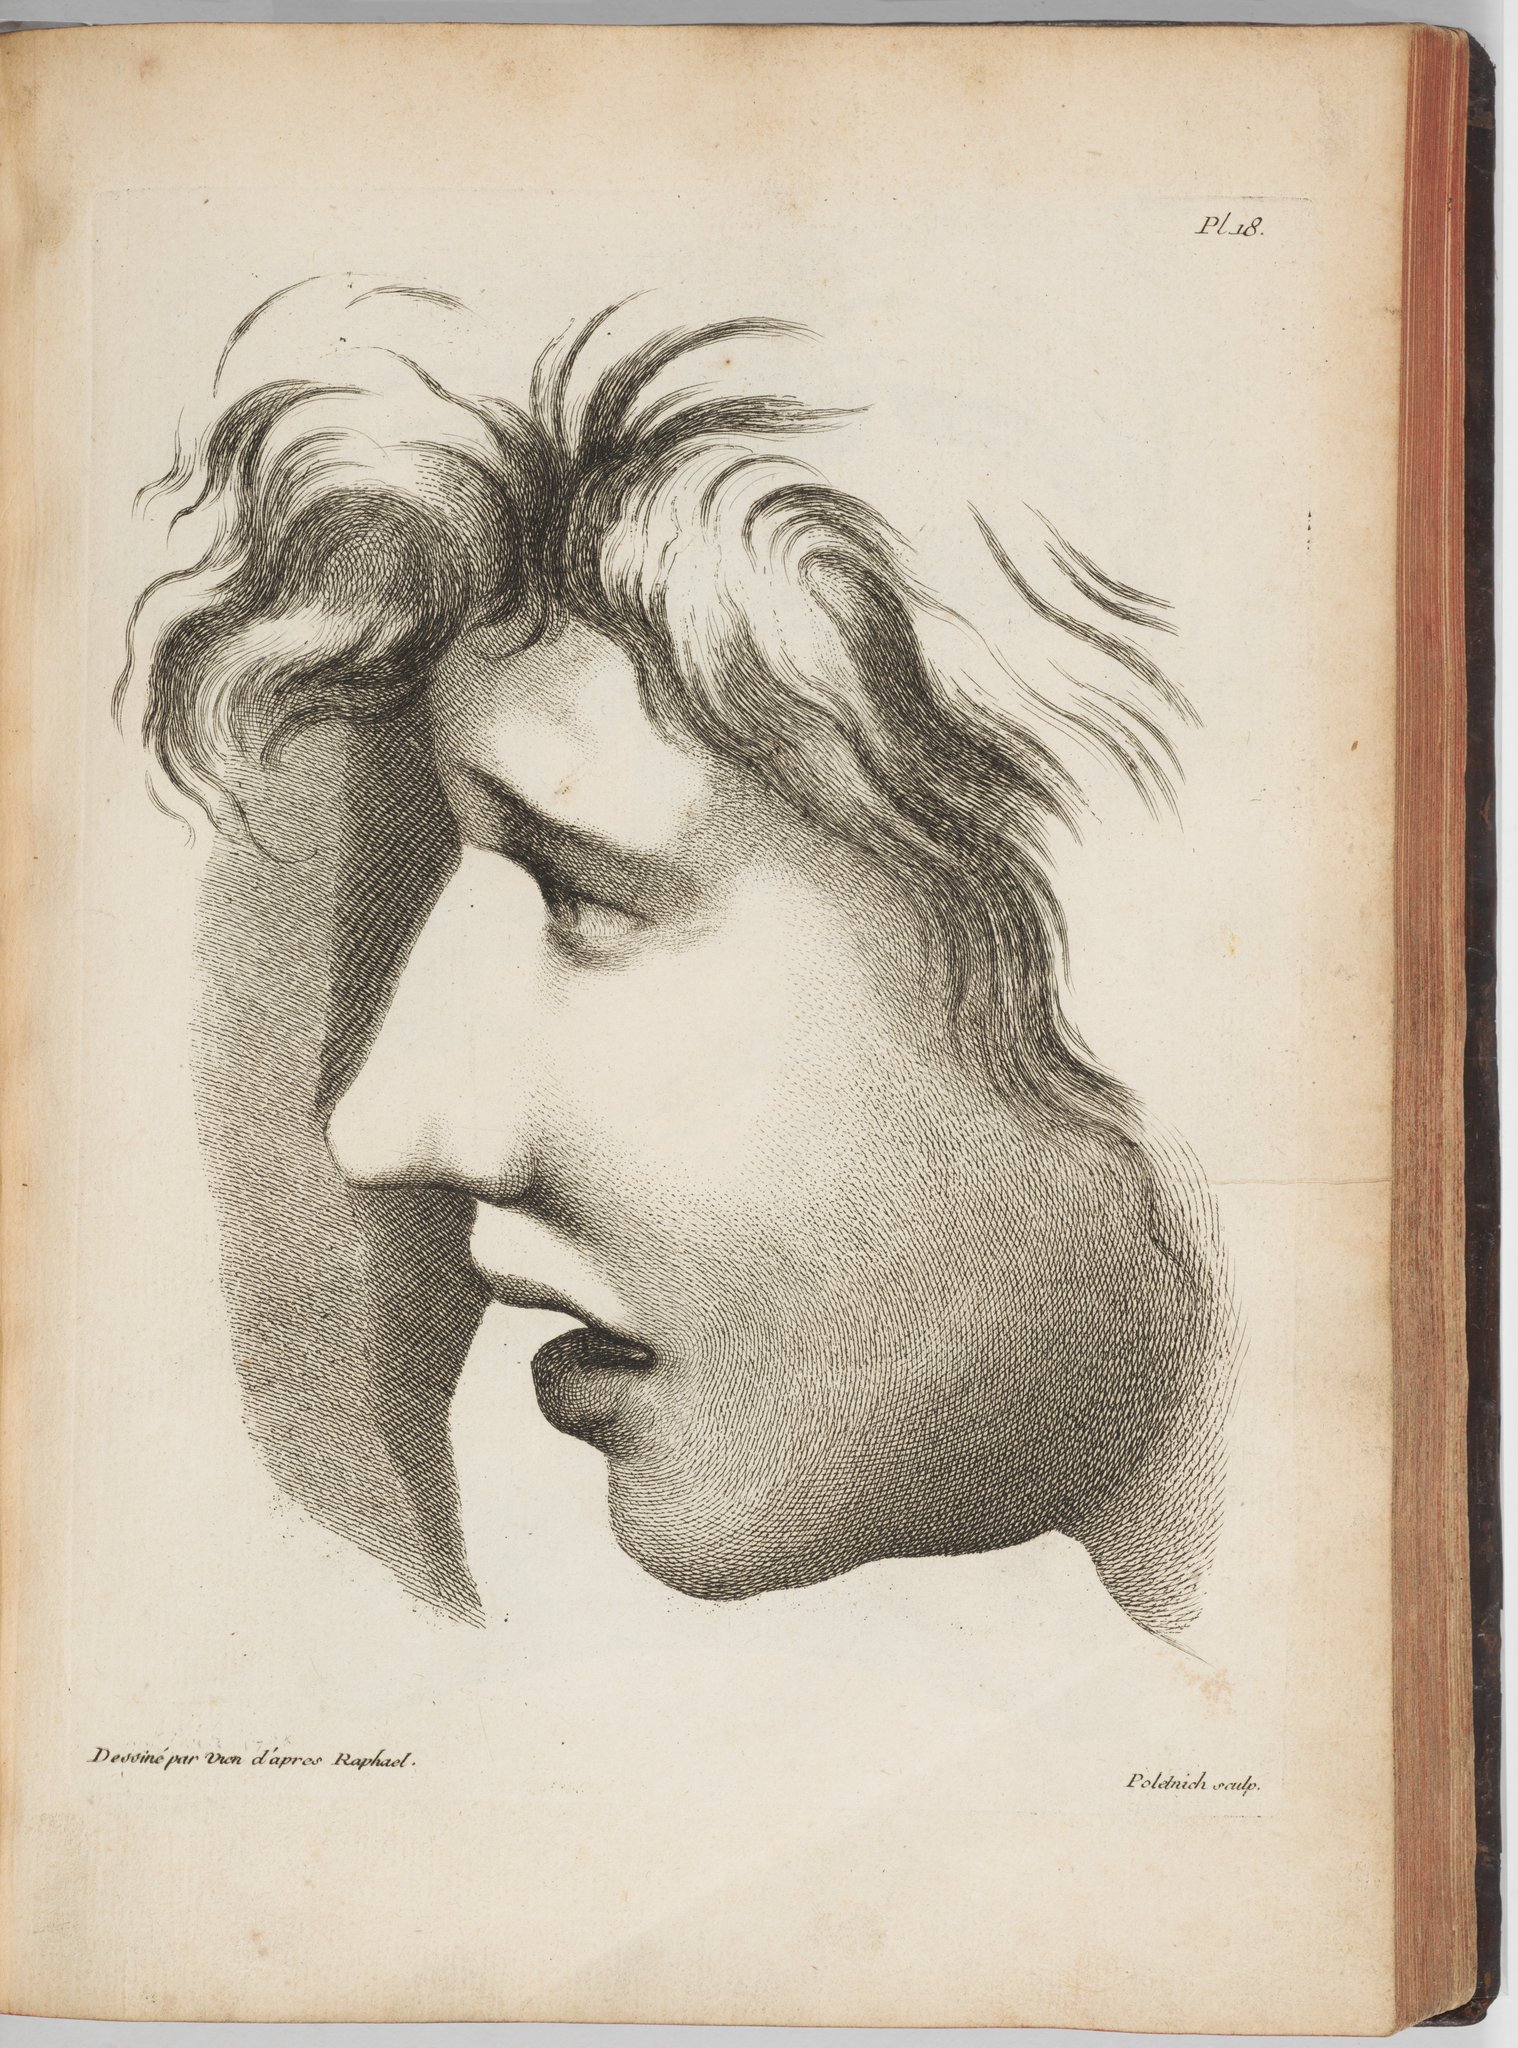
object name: book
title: Methode pour apprendre le Dessein...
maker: charles antoine jombert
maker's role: author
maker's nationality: french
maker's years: 1712-1784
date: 1755